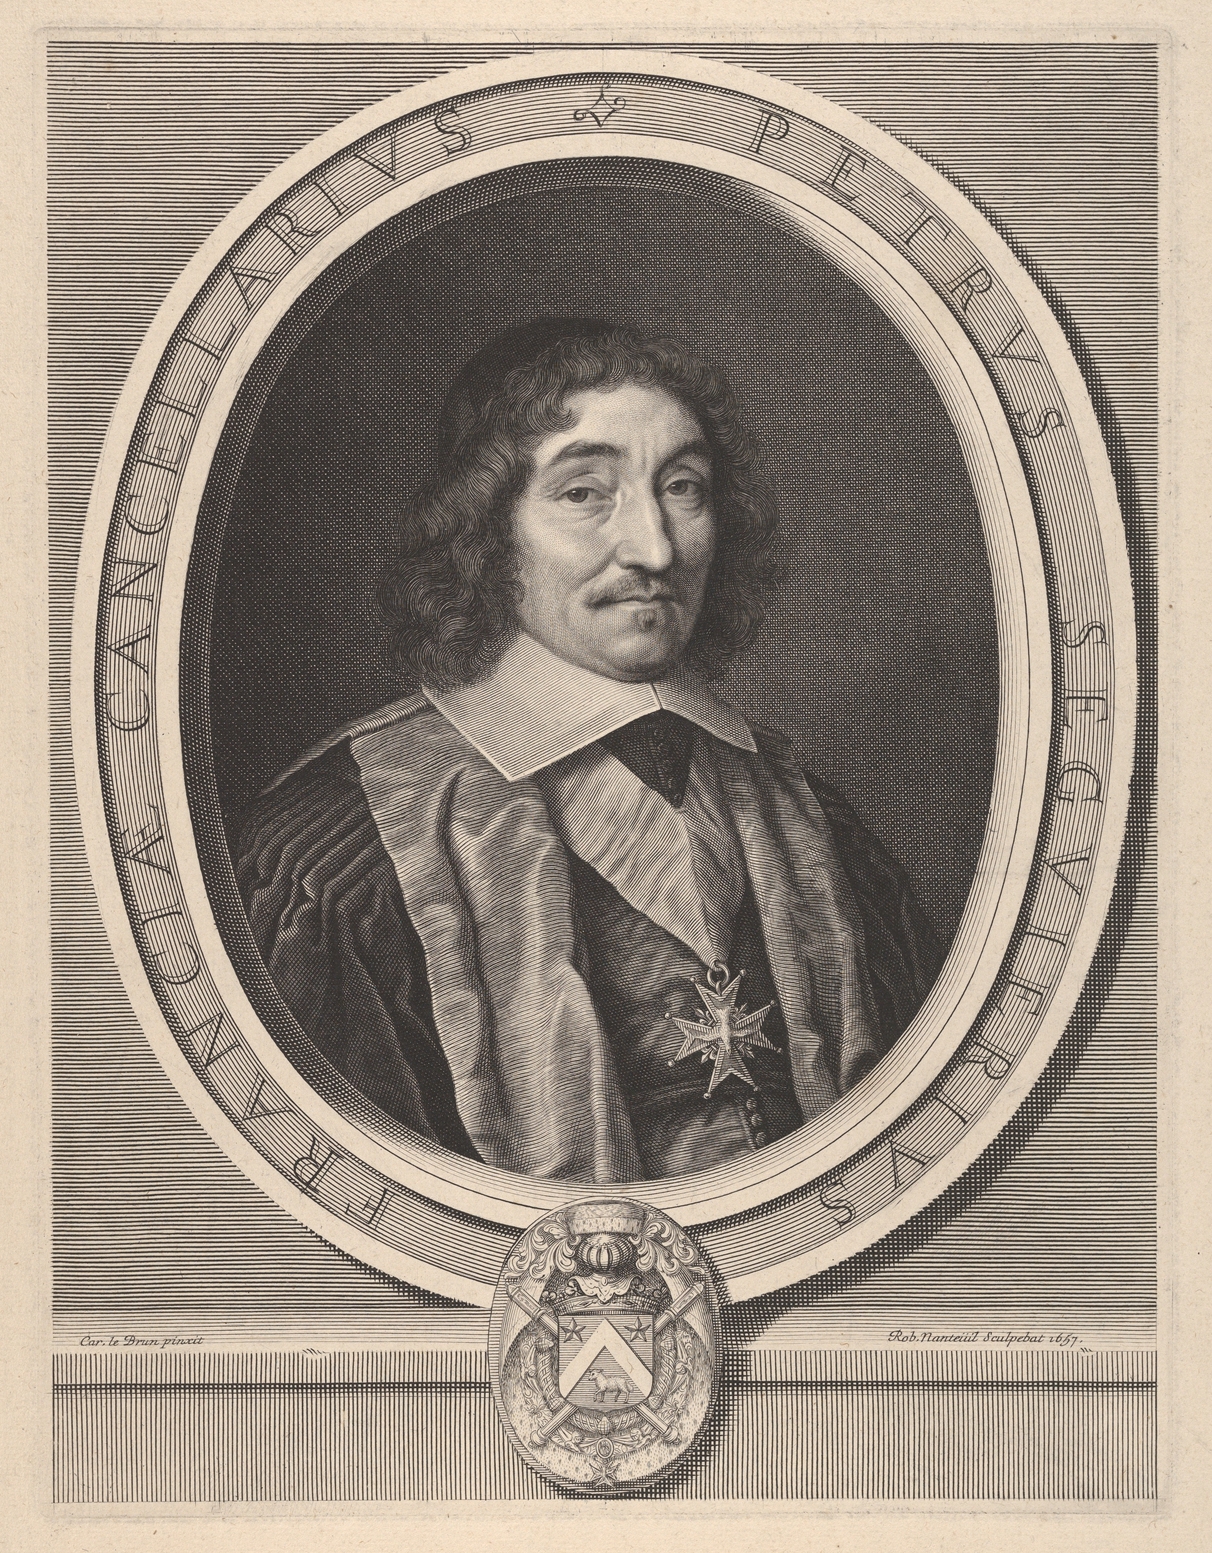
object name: print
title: Chanceliere Pierre Séguier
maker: robert nanteuil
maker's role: artist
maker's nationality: french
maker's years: 1623-1678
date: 1657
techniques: engraving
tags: men,portraits